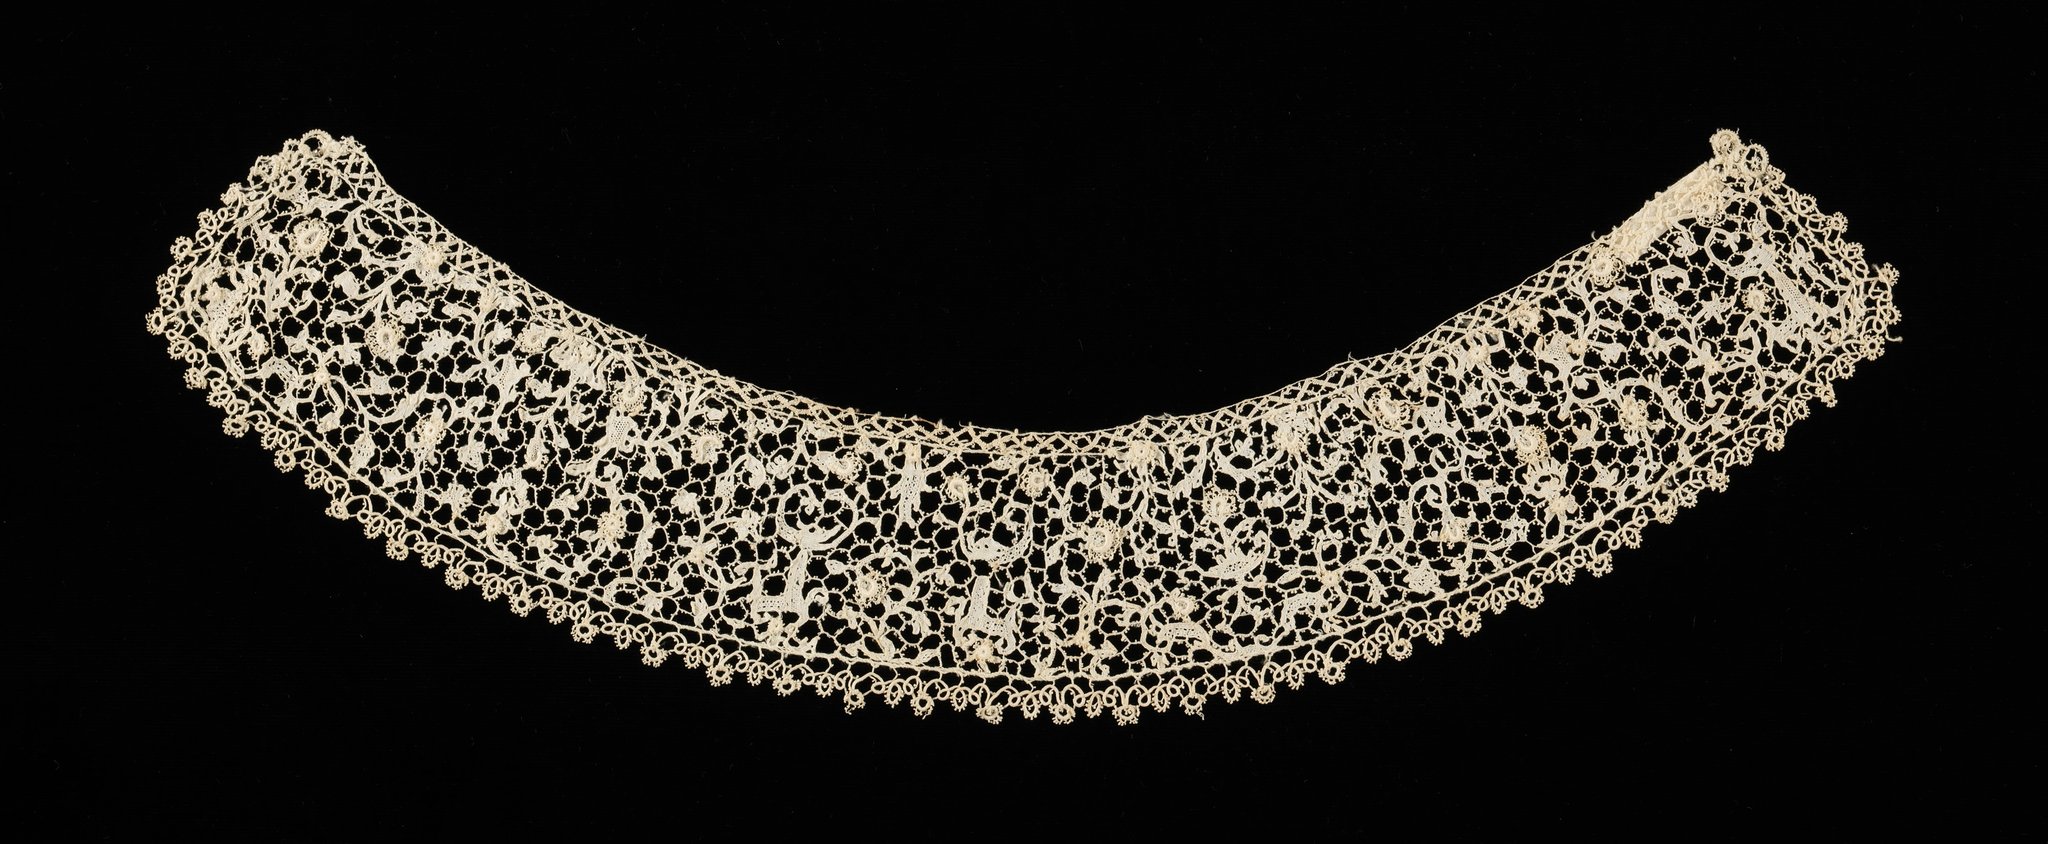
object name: collar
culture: european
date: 1850-1859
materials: linen